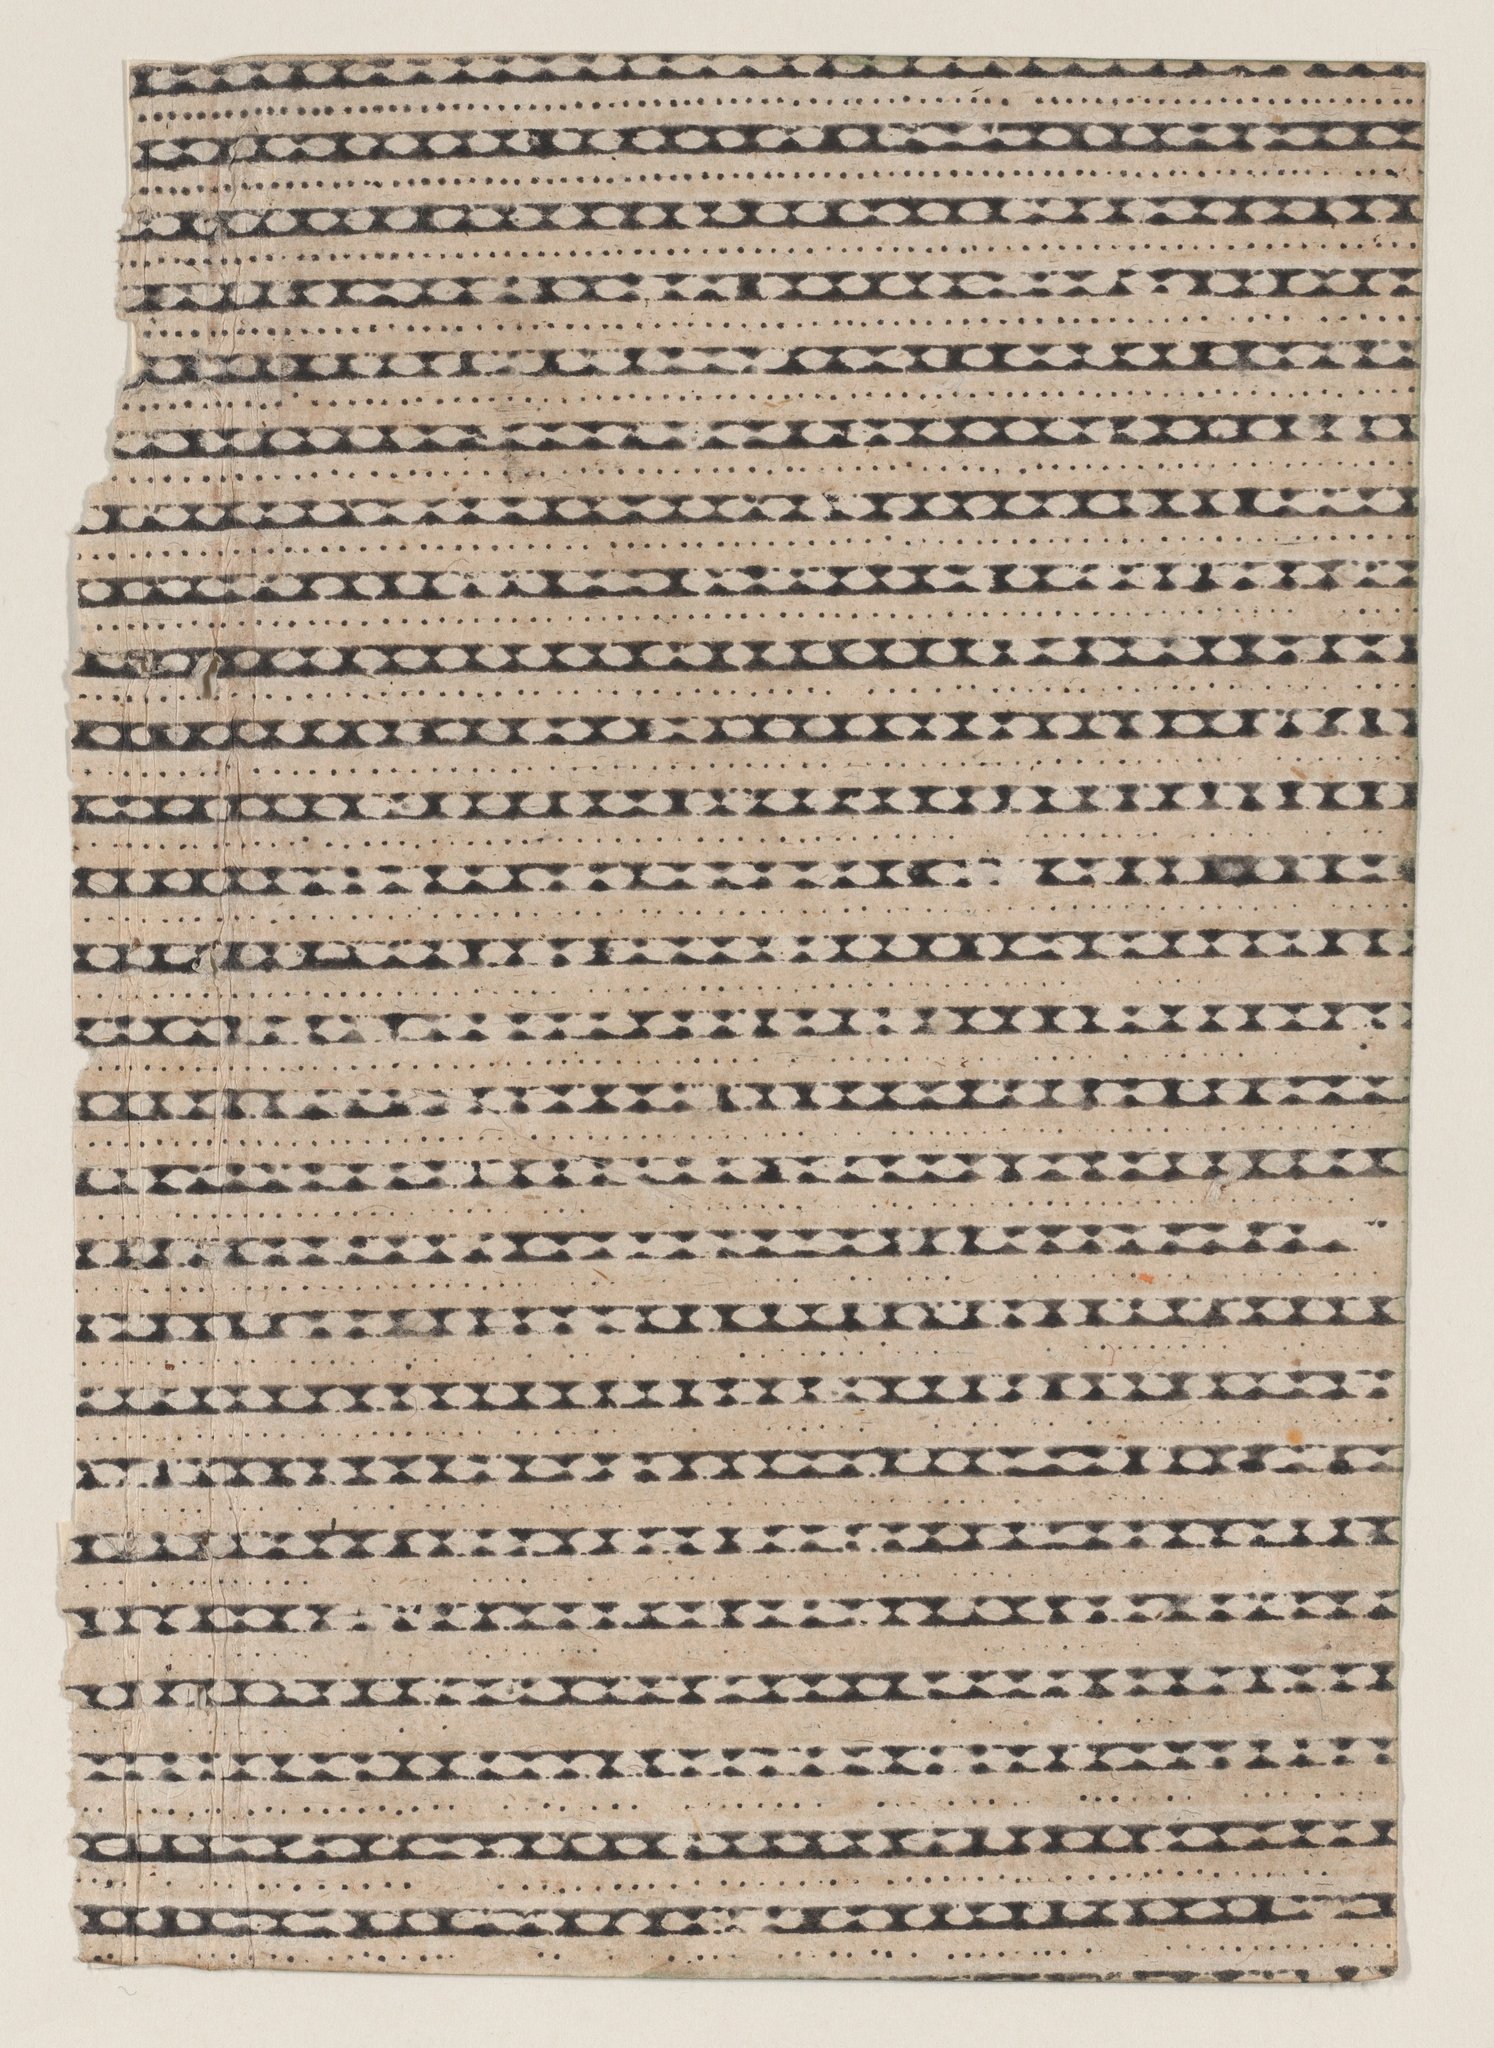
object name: print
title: Sheet with overall striped geometric pattern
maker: Anonymous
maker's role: artist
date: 1801-1900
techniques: relief print